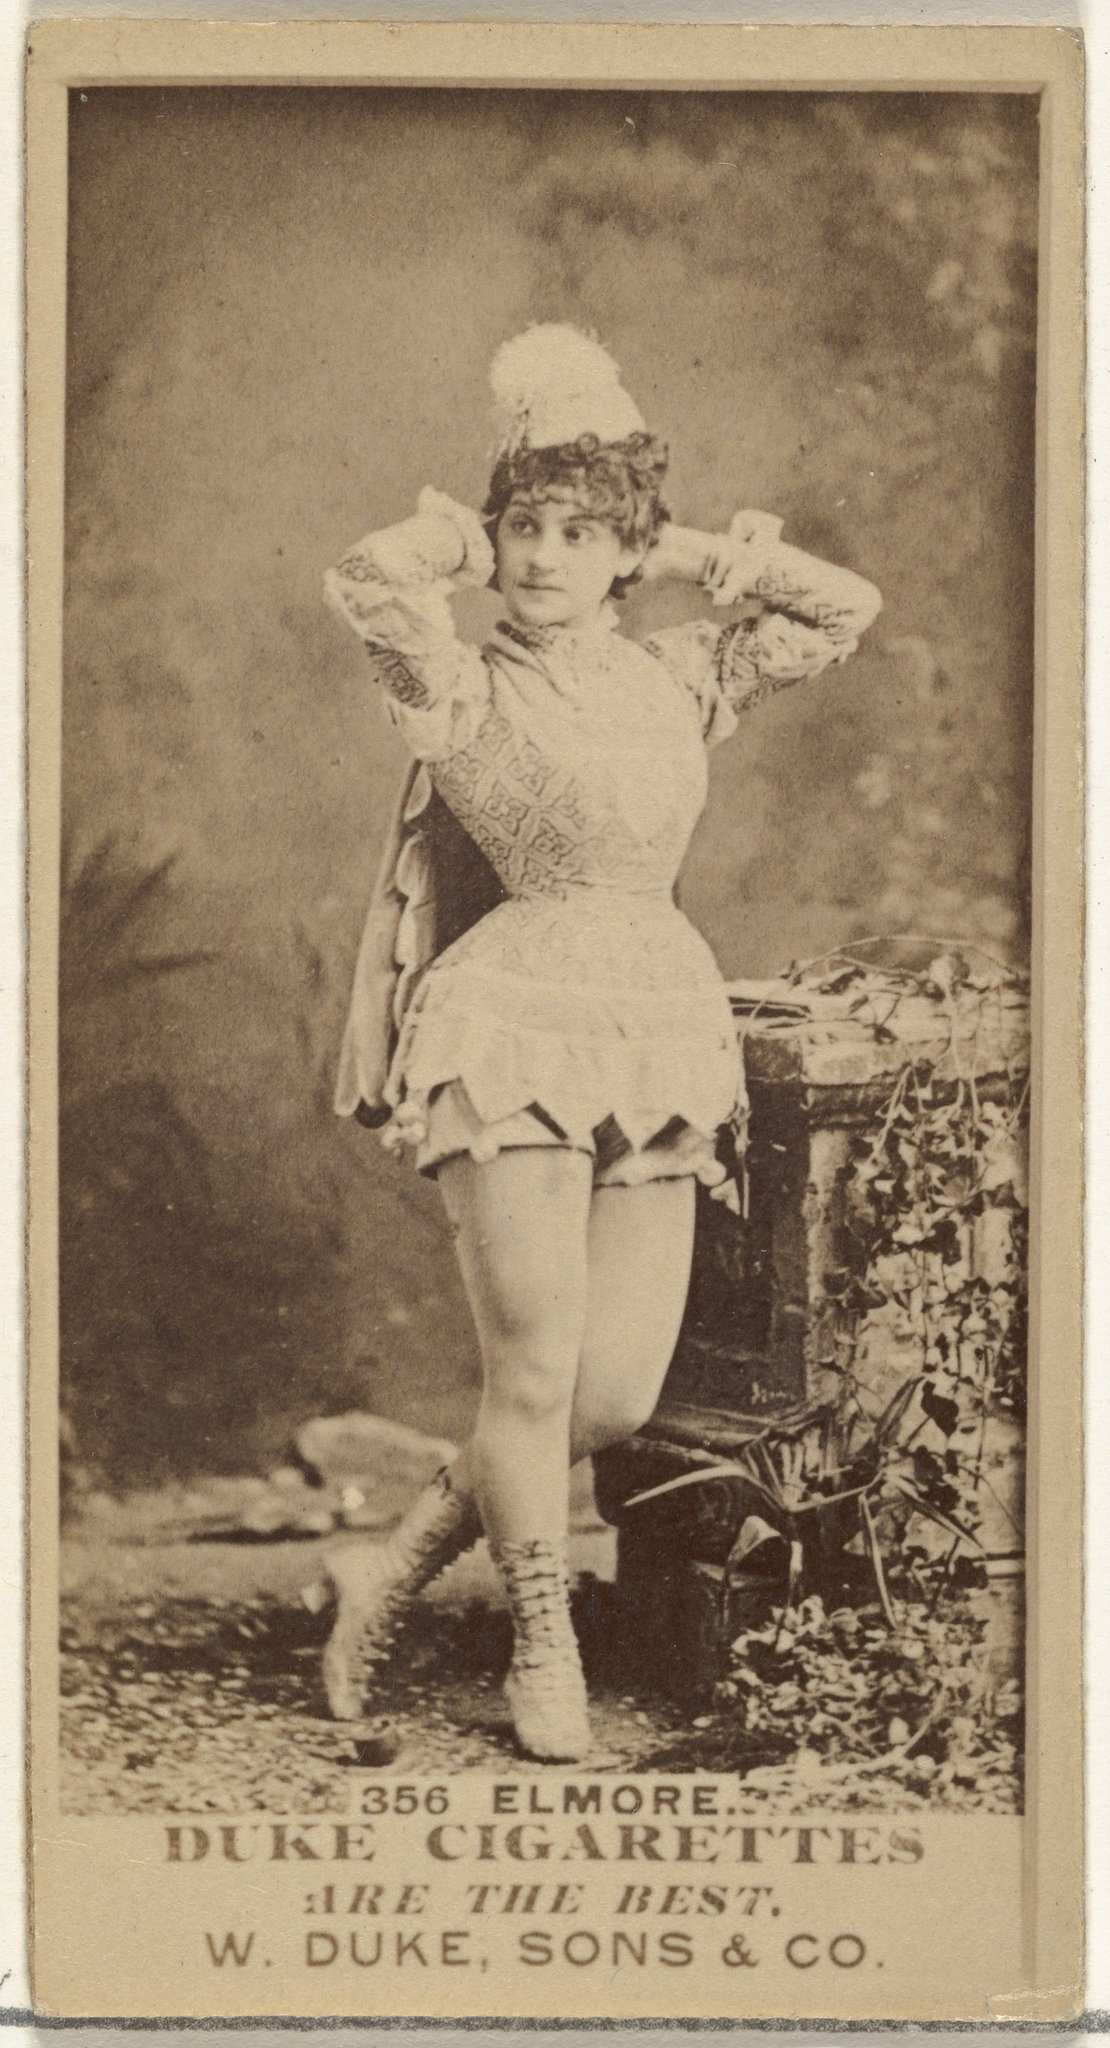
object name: photograph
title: Card Number 356, Miss Elmore, from the Actors and Actresses series (N145-7) issued by Duke Sons & Co. to promote Duke Cigarettes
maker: w. duke, sons & co.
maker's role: publisher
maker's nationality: american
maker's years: 1870-1920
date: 1880-1889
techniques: albumen silver print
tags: portraits,women,actresses